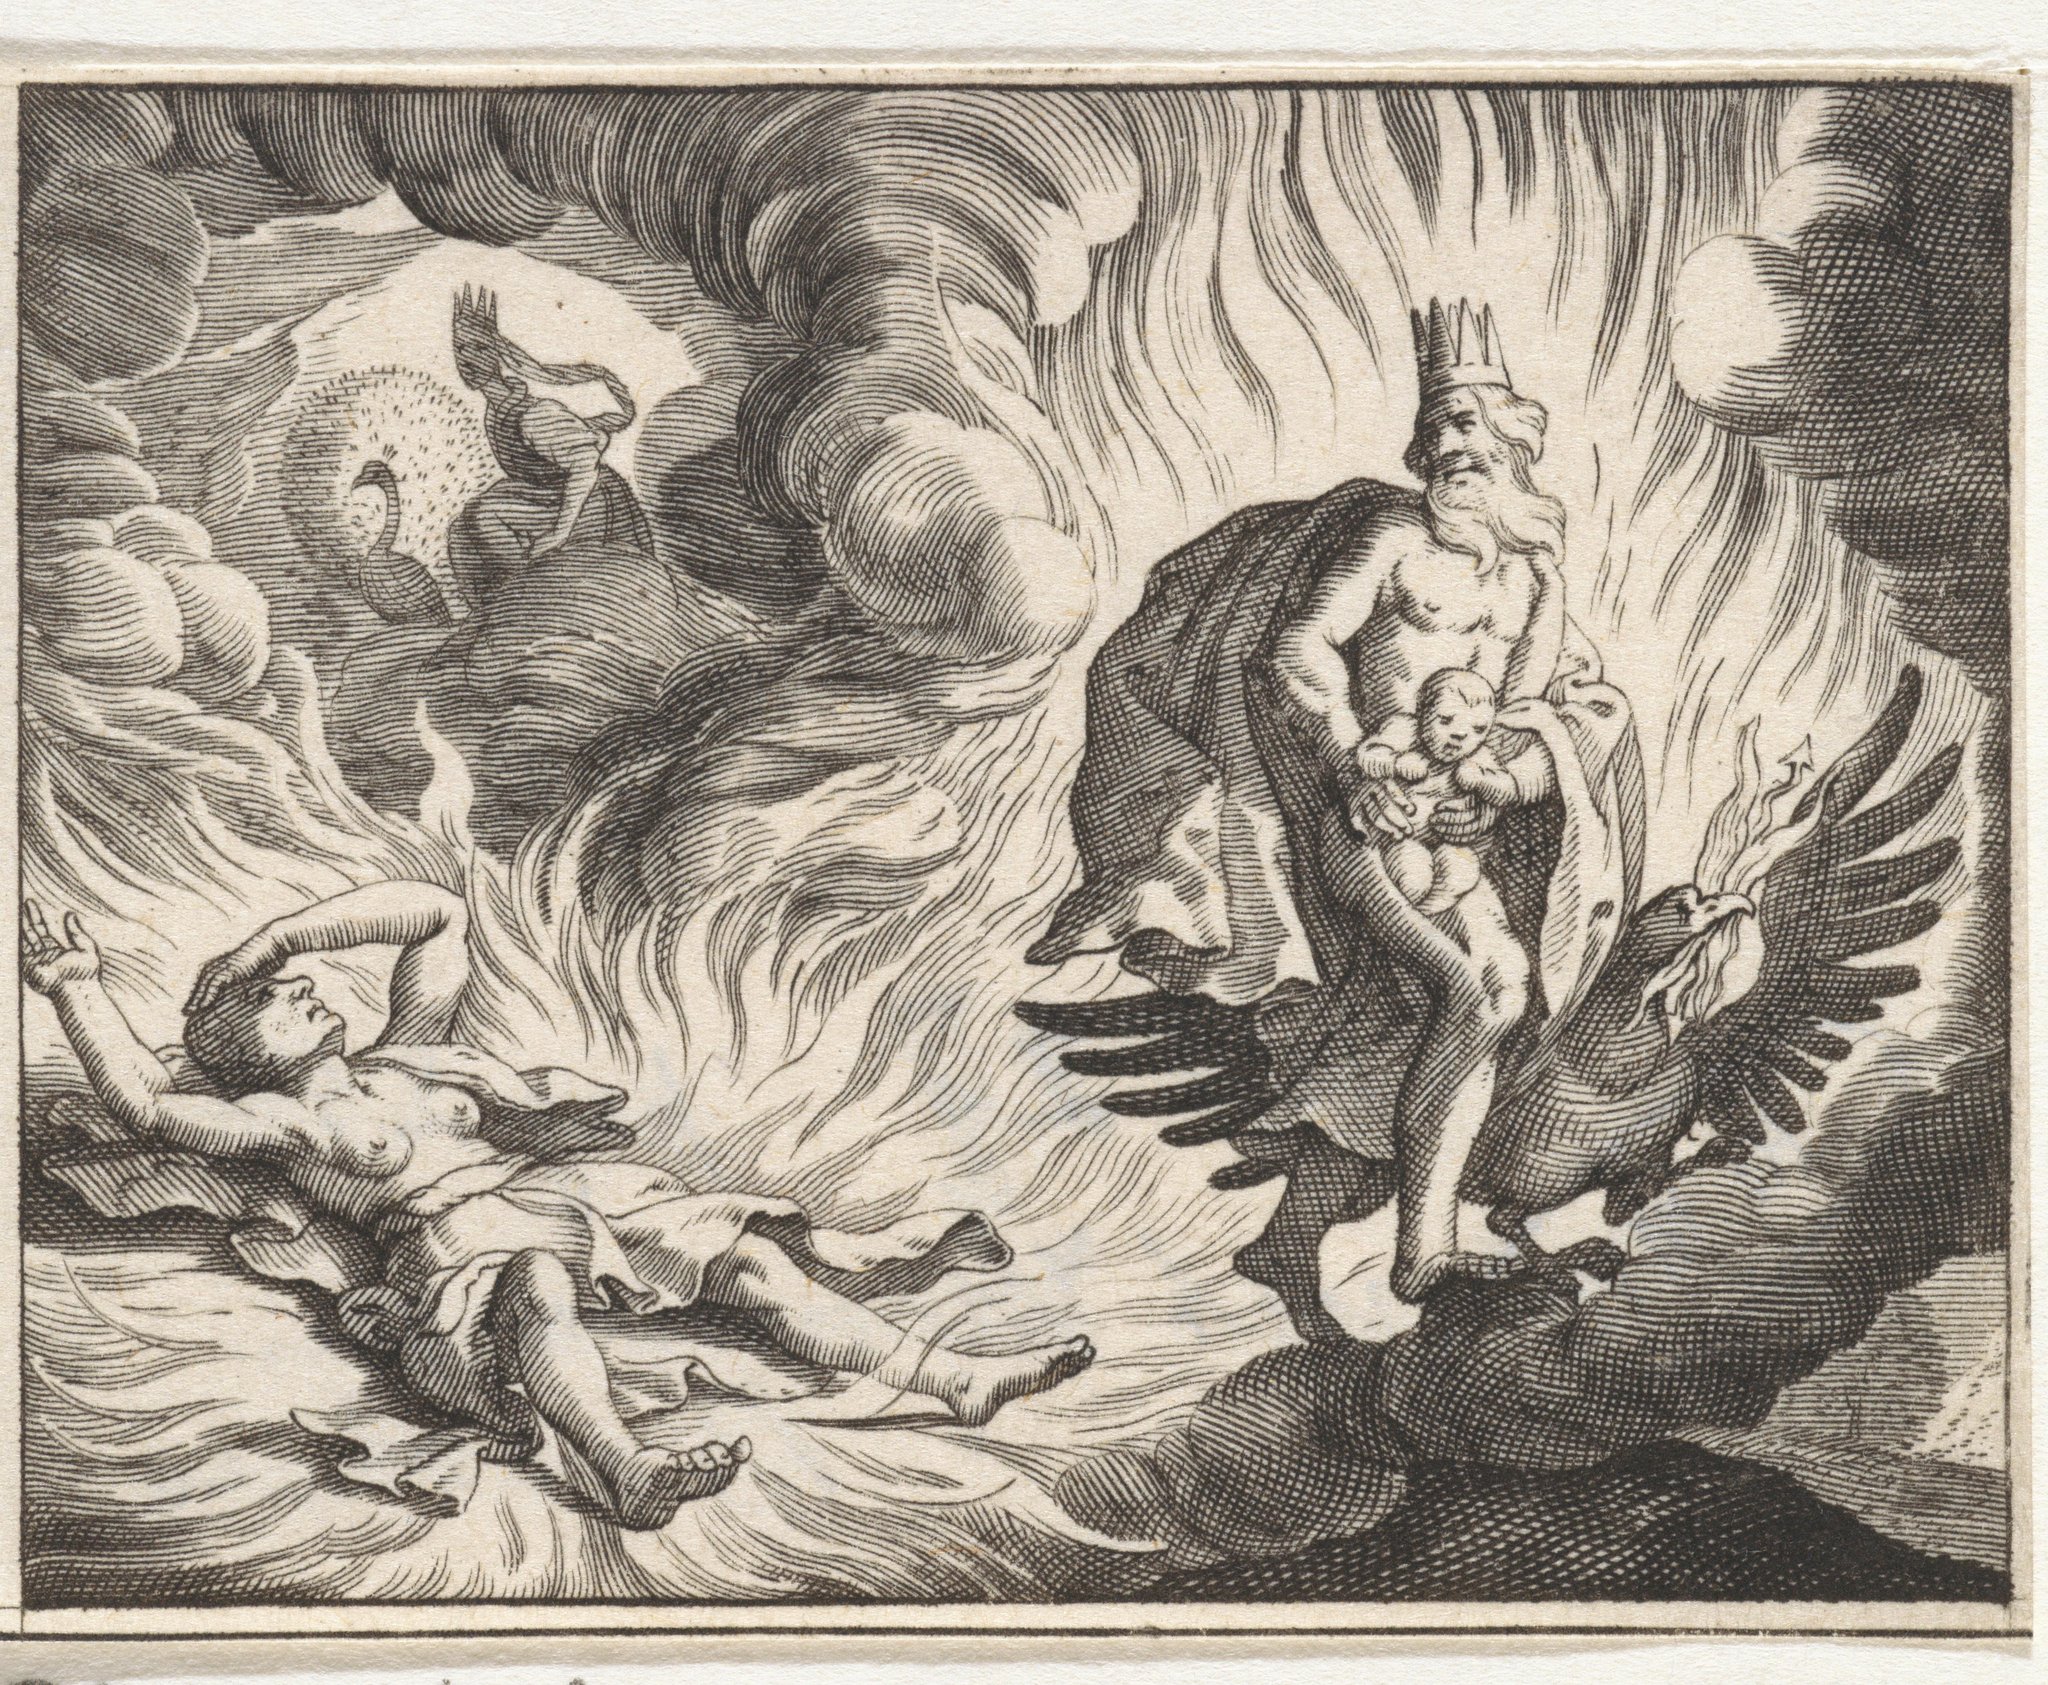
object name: print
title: Geboorte van Bacchus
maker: pieter serwouters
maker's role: draughtsman, print maker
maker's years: 1586-1657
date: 1616-1657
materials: paper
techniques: engraving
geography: amsterdam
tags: juno, in the guise of an old woman (beroe) induces semele to ask jupiter to show himself to her in all his divine splendour, suffering, misfortune of semele, birth of bacchus: he is born from jupiter's thigh, where he had been sewn in (possibly by mercury)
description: Jupiter met kroon op het hoofd en naast hem zijn attribuut de adelaar, loopt weg van Bacchus' moeder Semele, die door Jupiters bliksem wordt verteerd. Daarop wordt Bacchus uit de dij van Jupiter geboren. Op de achtergrond Juno, die Semele had verleid Jupiter te vragen zich in zijn ware gedaante te tonen.